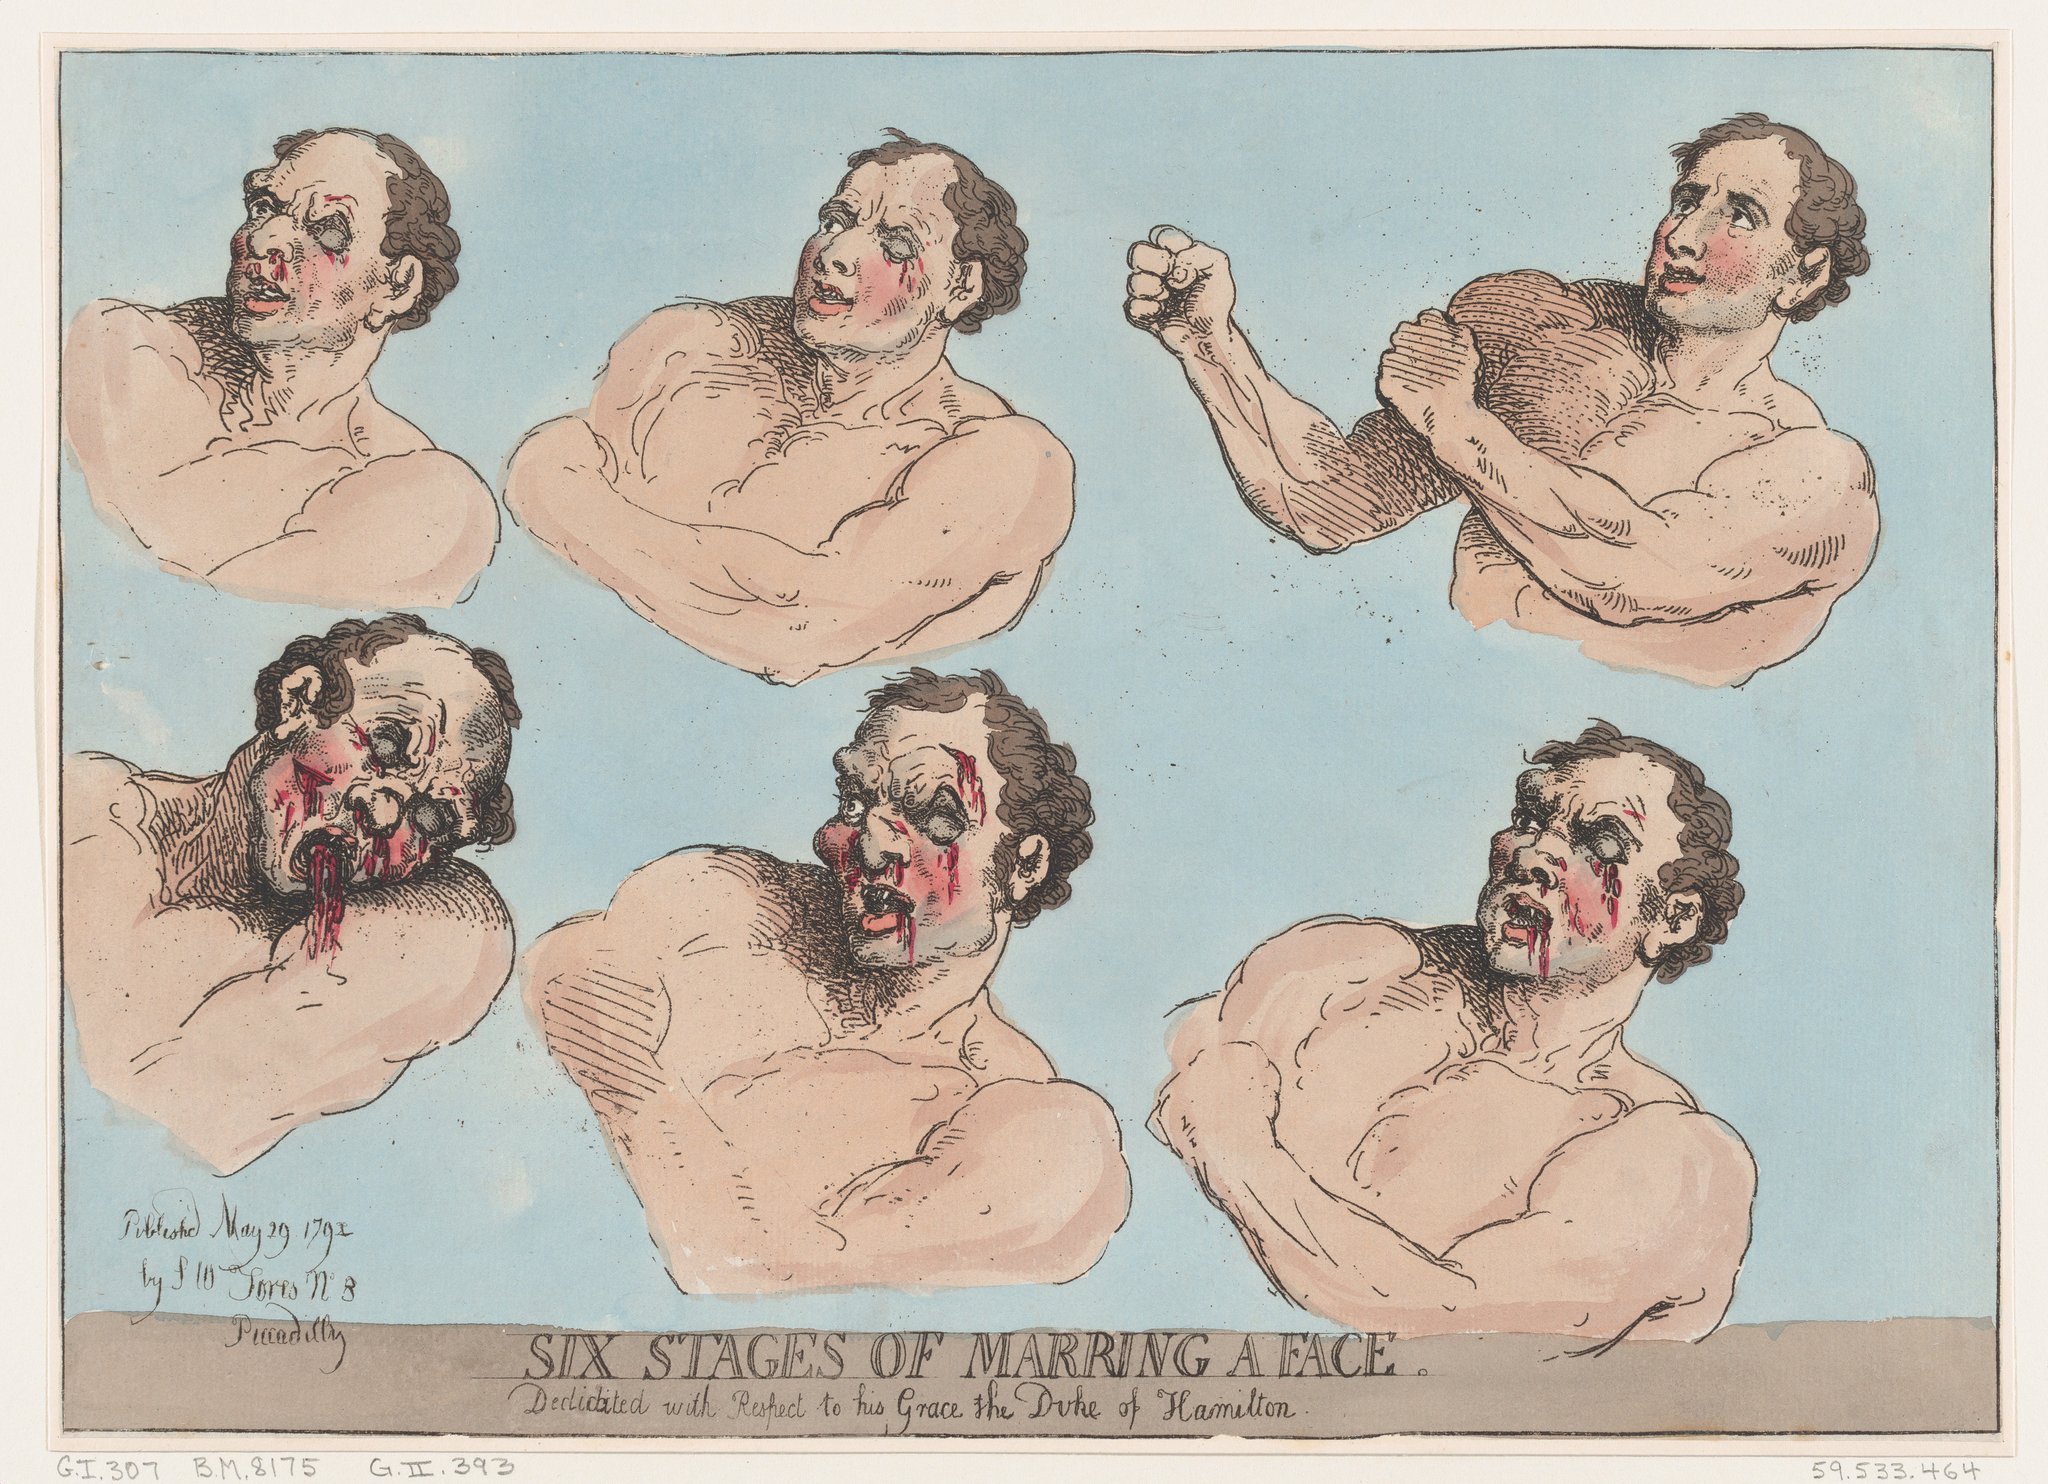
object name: print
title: Six Stages of Marring a Face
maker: thomas rowlandson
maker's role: artist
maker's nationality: british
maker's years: 1757-1827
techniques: etching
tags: men